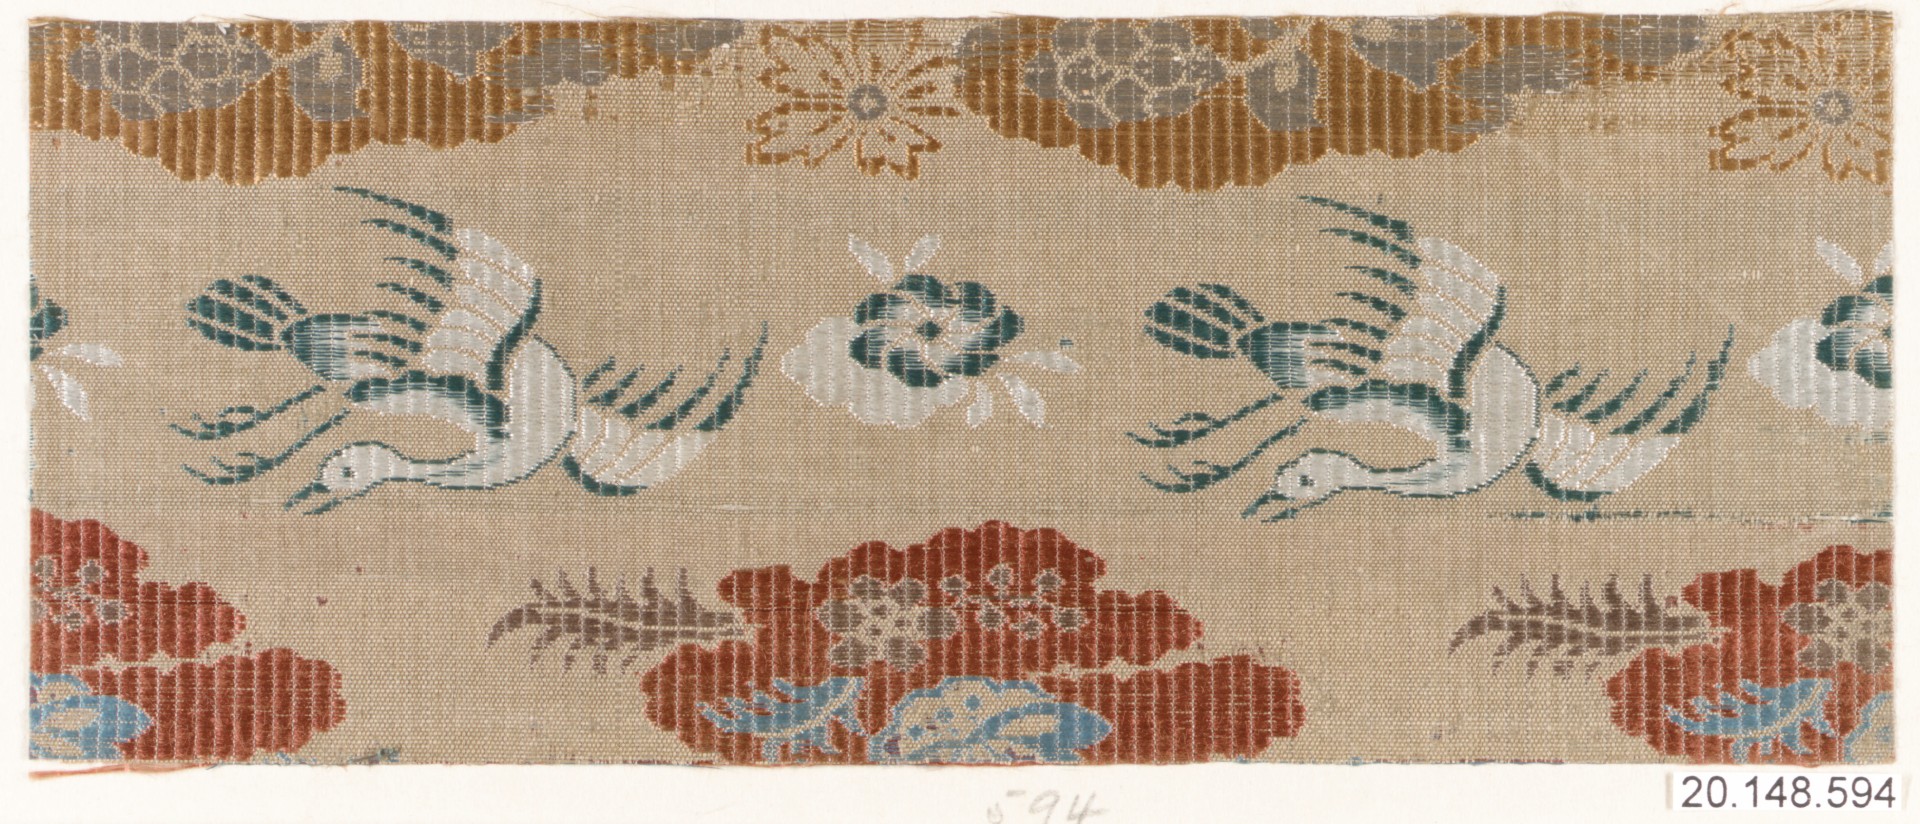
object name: piece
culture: japanese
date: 1601-1700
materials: silk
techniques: compound weave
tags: cranes